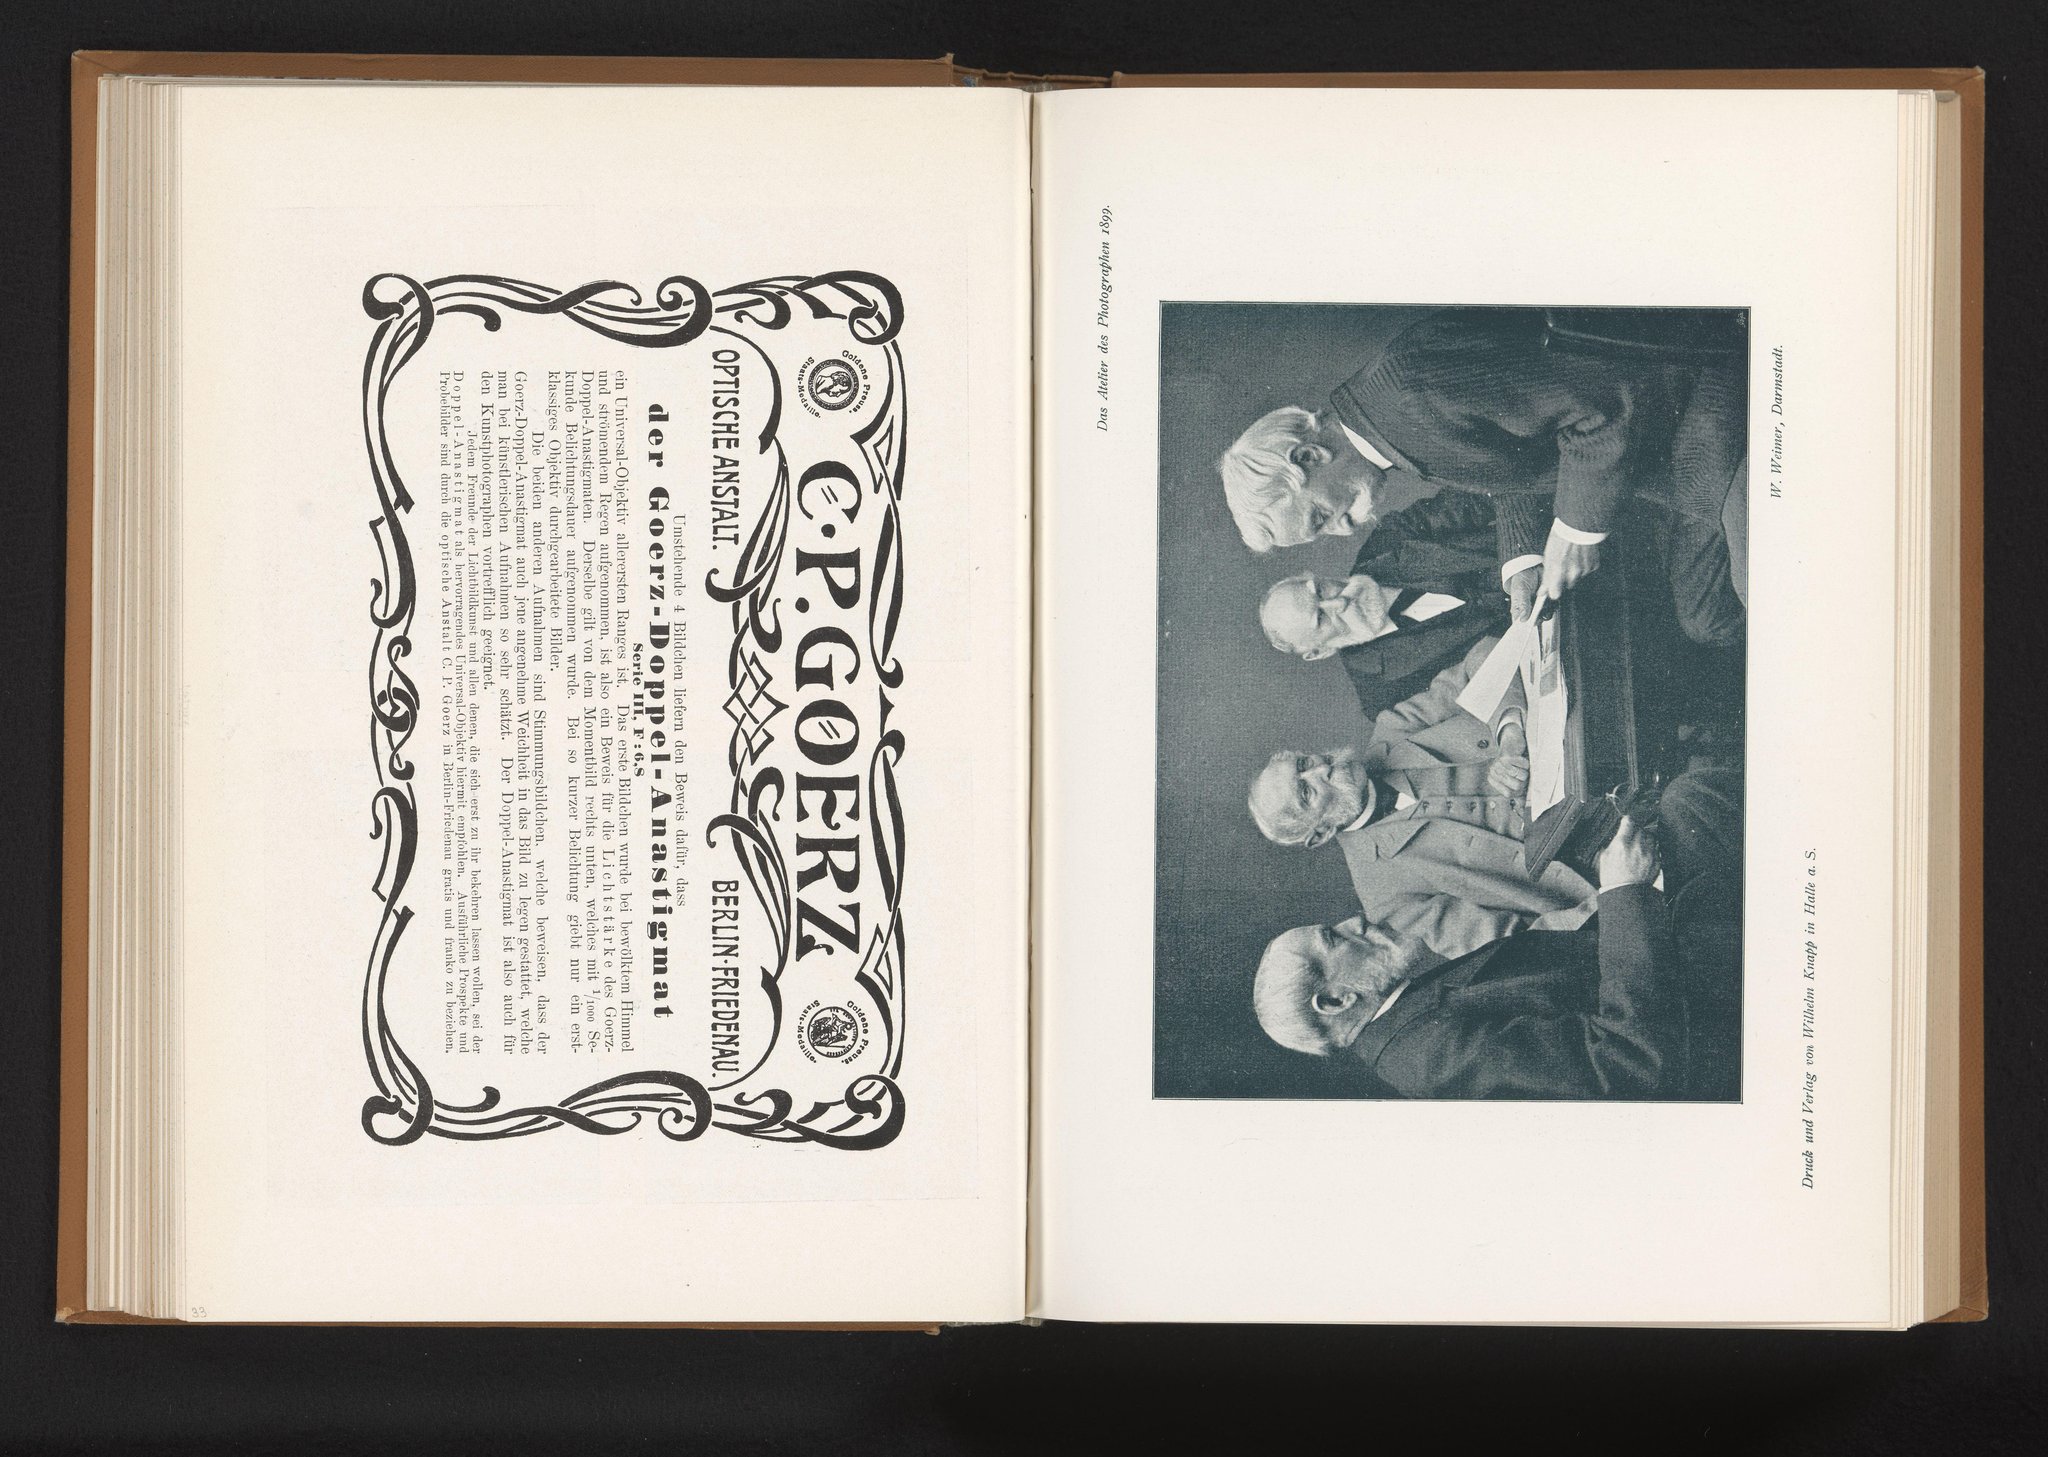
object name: page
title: Vier mannen aan een tafel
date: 1895-1900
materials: paper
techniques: autotype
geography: halle an der saale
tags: adult man (+ four persons)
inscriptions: inscription: ‘Das Atelier des Photographen.’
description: Prent op derde ongenummerde pagina na pagina 124.